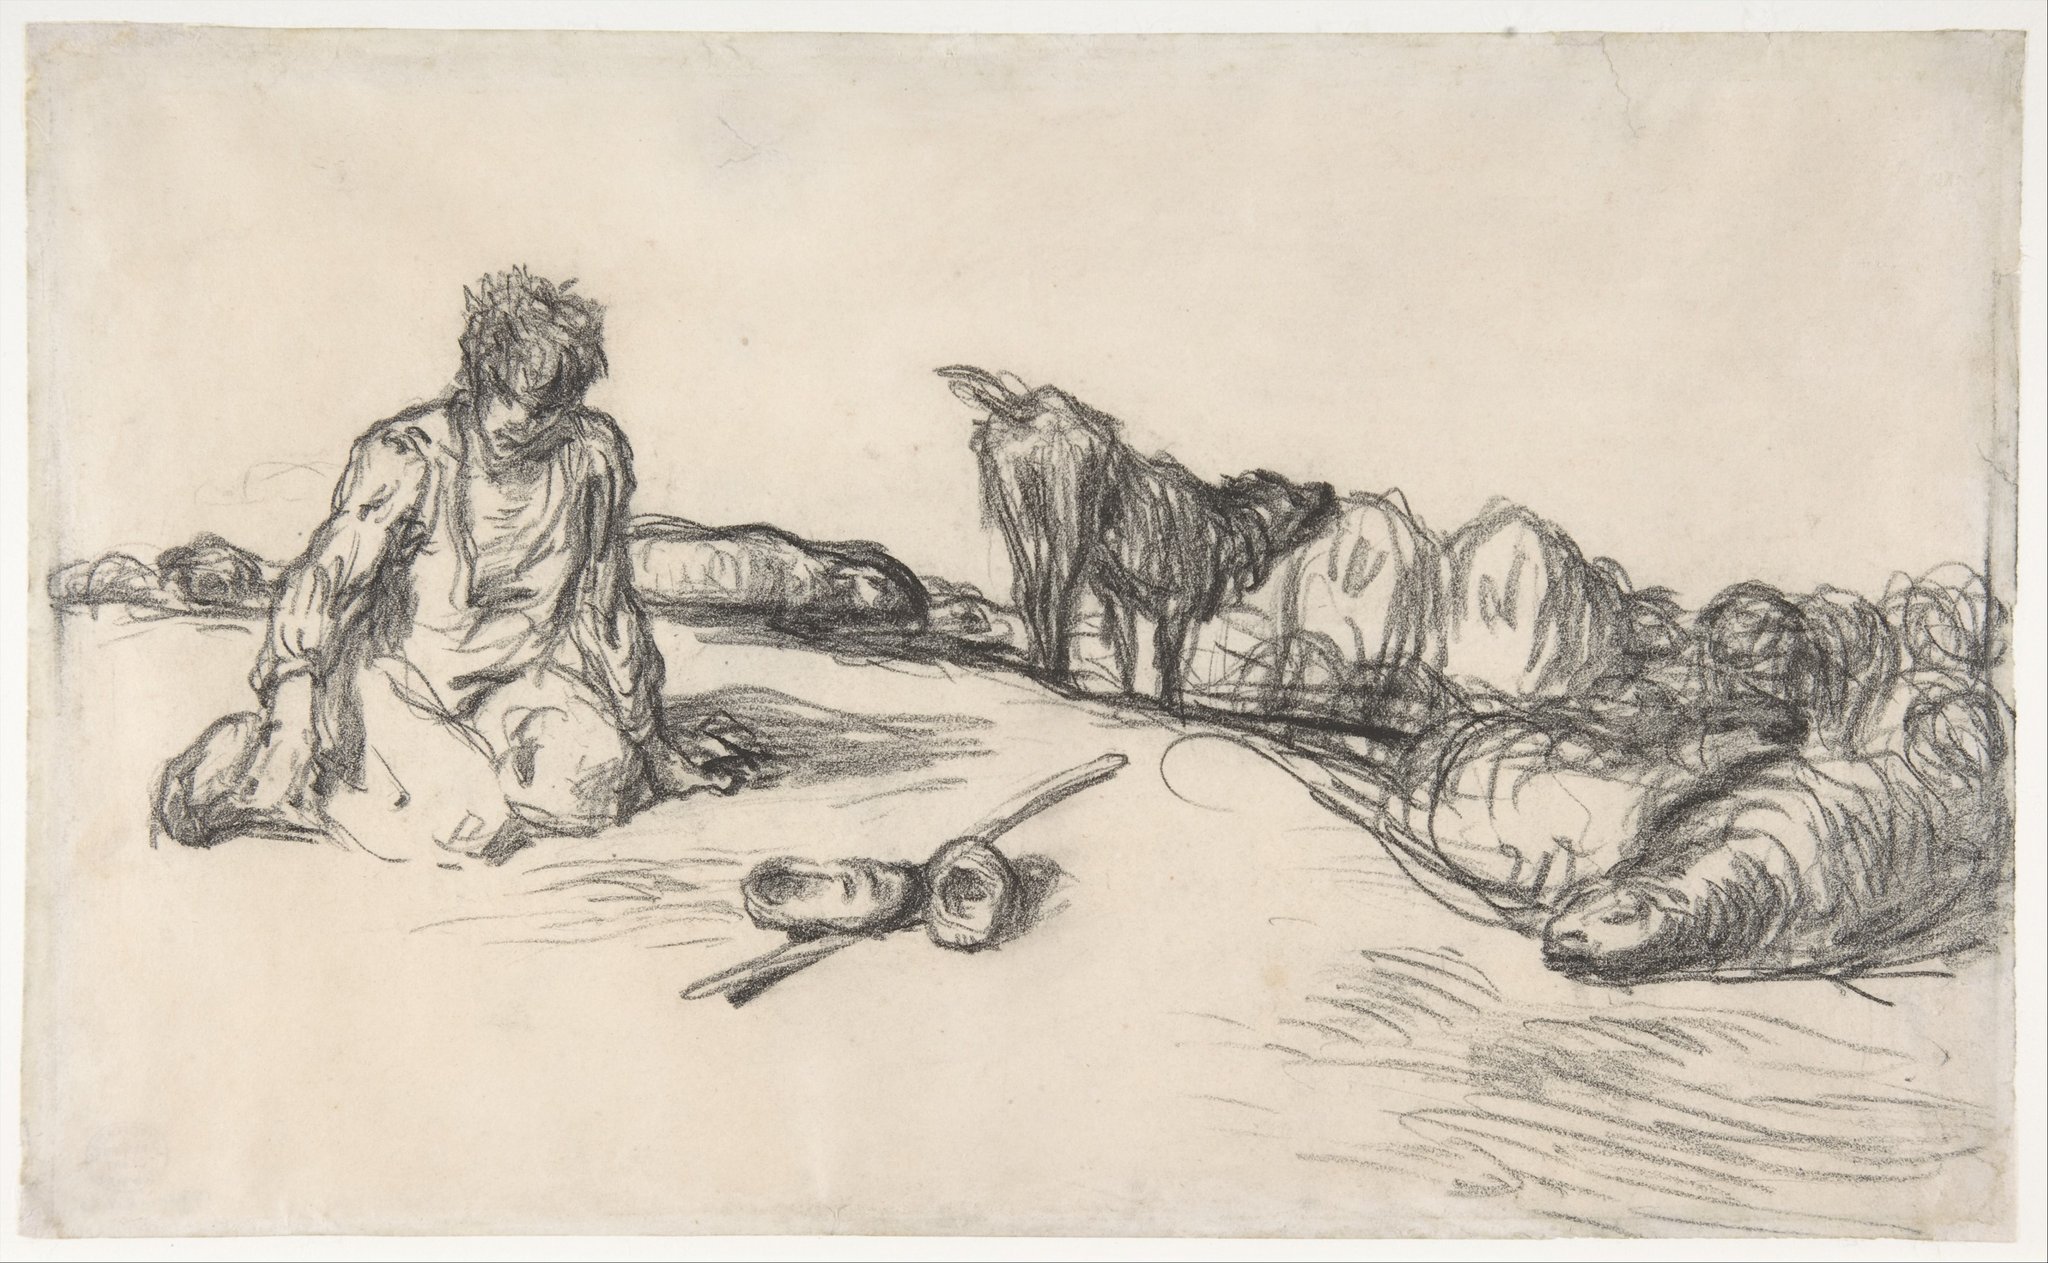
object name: drawing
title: A Seated Shepherd with His Dog and Sheep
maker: jean-françois millet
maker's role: artist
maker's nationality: french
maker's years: 1814-1875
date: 1830-1875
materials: crayon, paper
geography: france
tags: dogs,sheep,shepherds